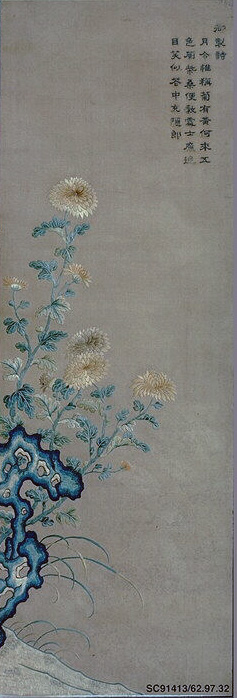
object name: panel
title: Chrysanthemums, Rocks, and Grasses Representing Autumn; from Set of Four Panels Representing the Four Seasons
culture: chinese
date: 1701-1800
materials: paint, silk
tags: flowers,plants